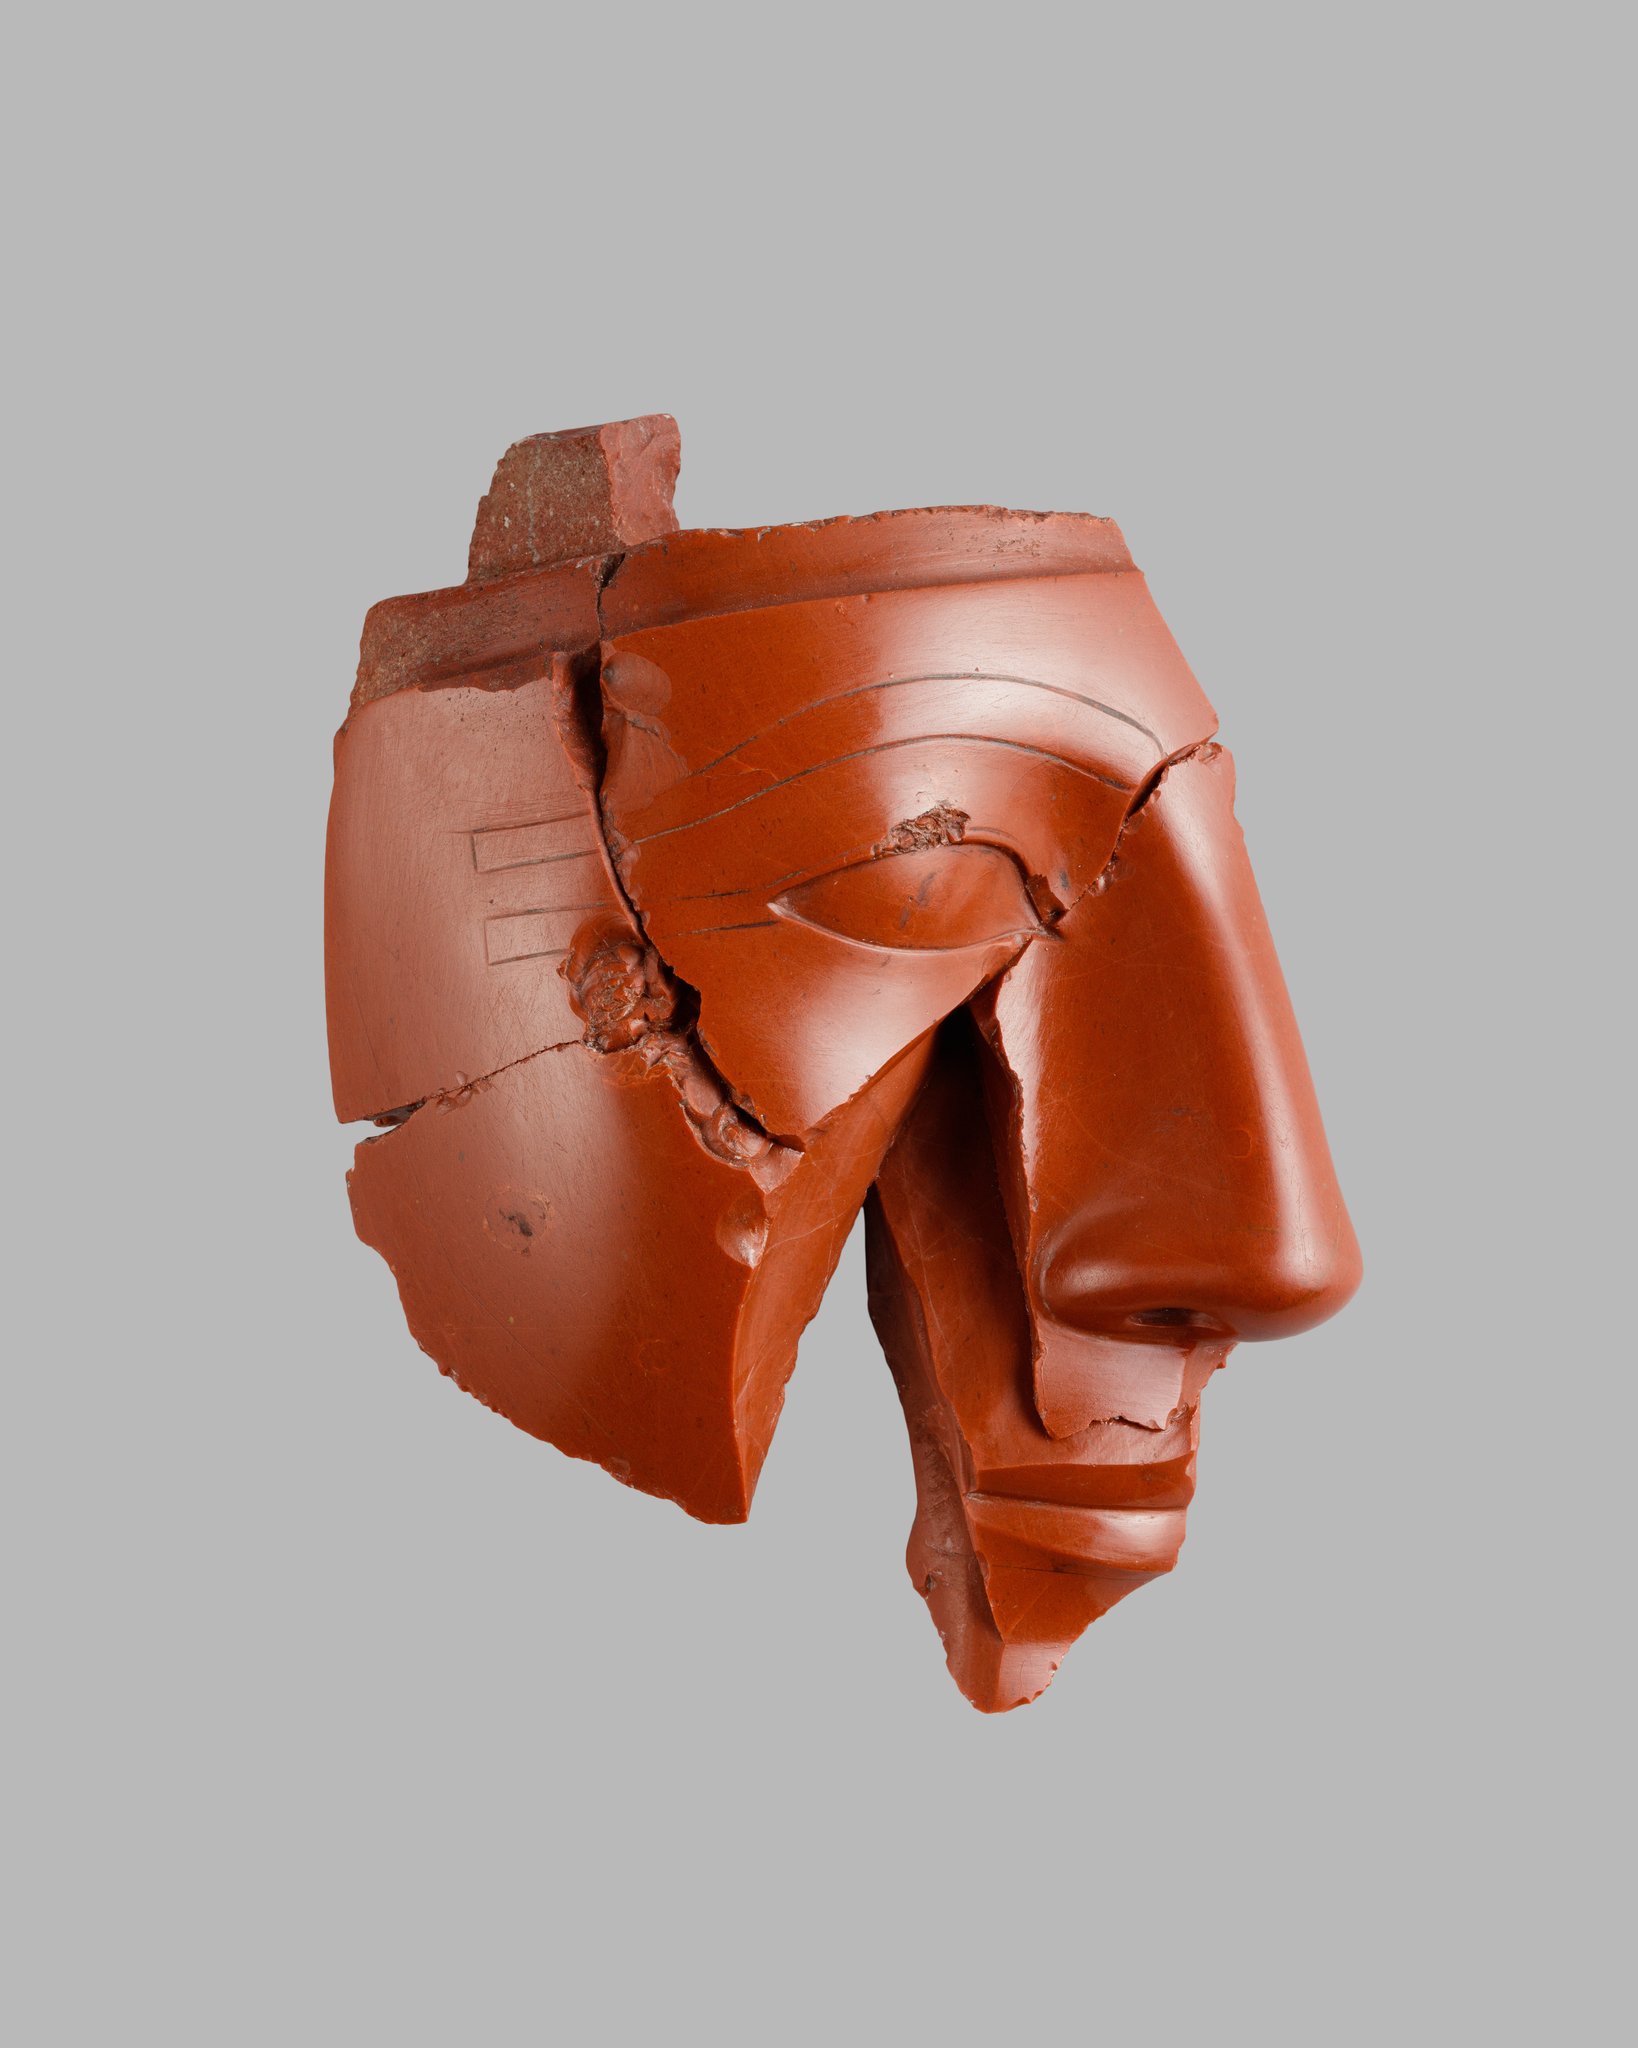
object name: head fragment, king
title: Fragmentary Head of a King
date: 1400-1390 BCE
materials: jasper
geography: egypt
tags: kings,heads